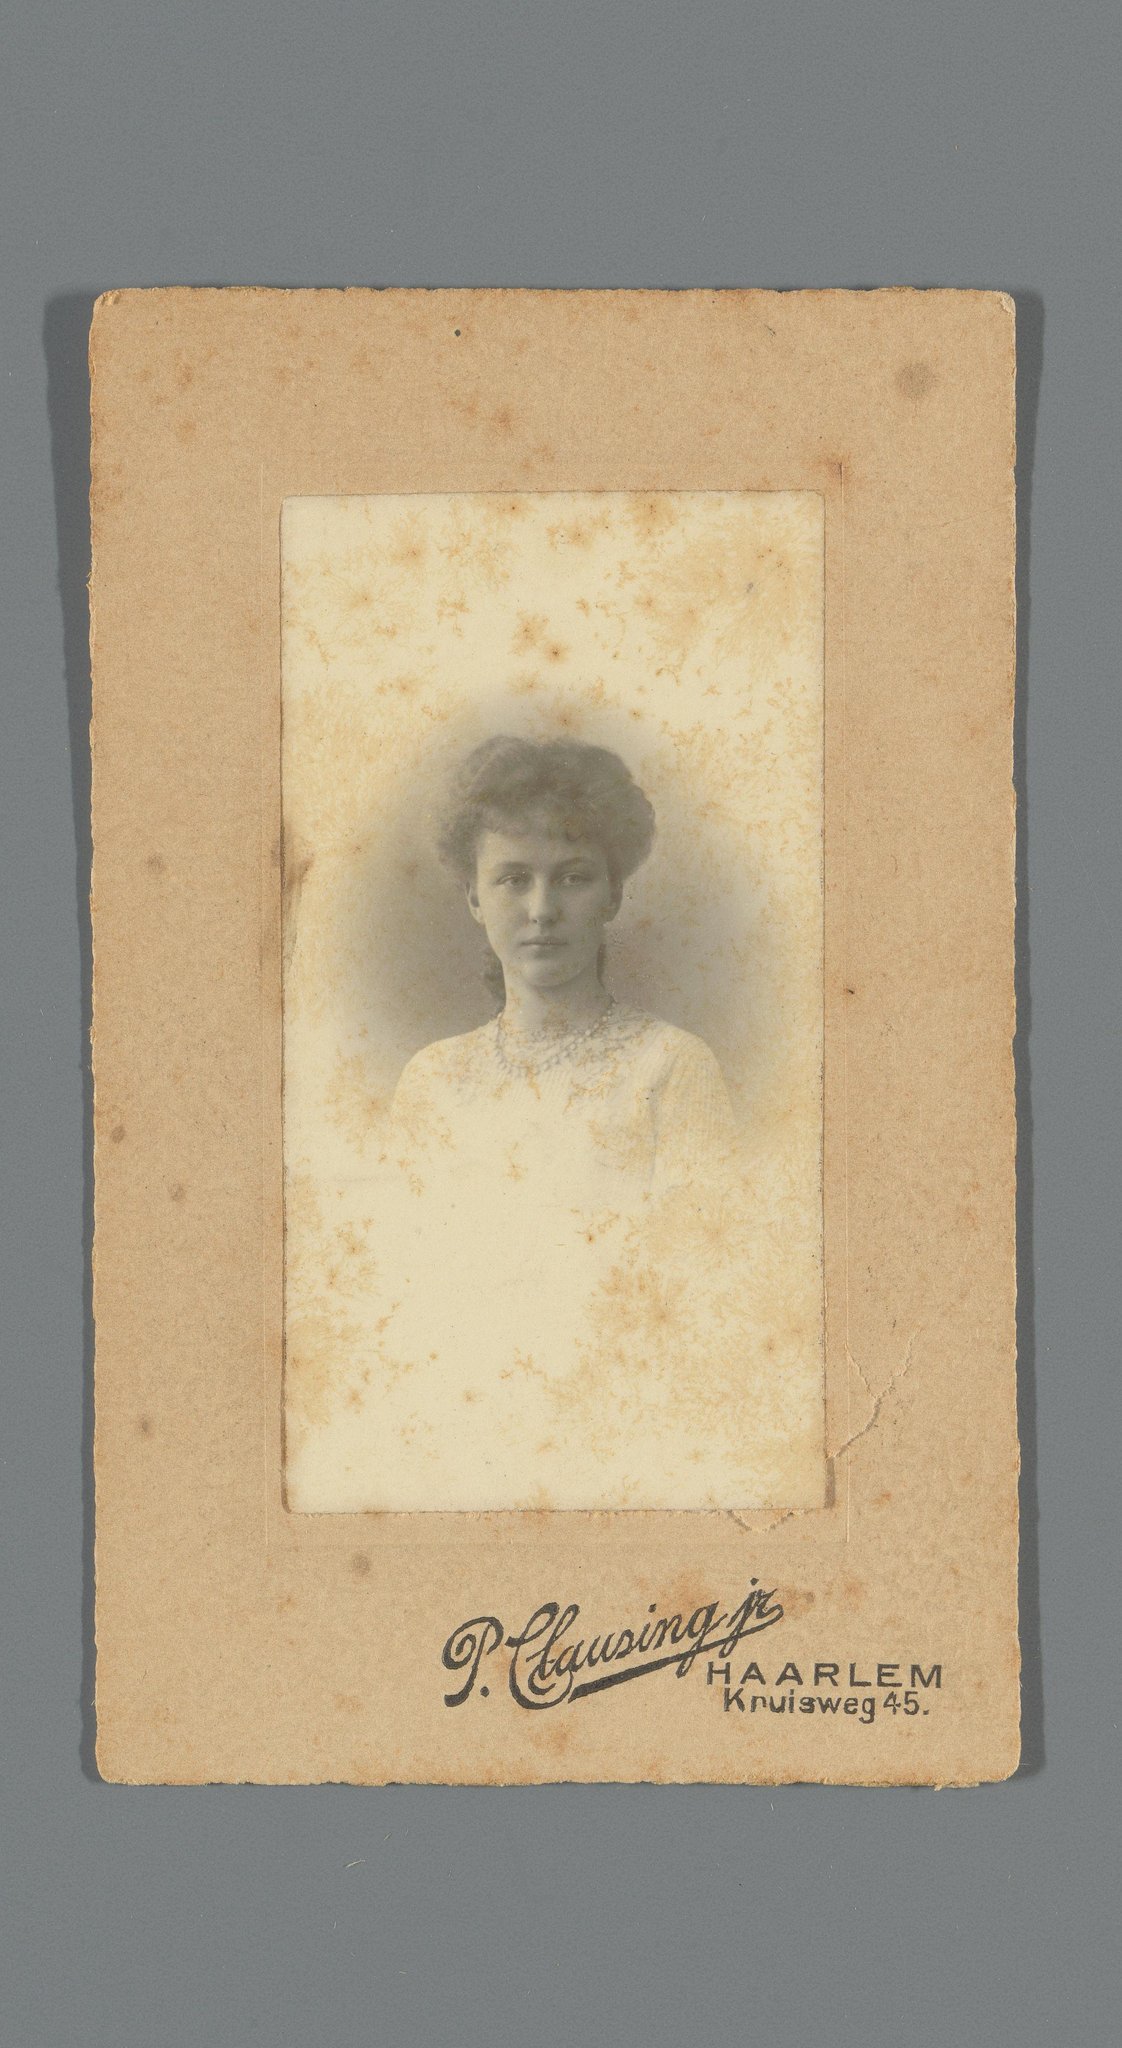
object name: carte de visite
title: Portret van Jkvr. Ida Helena Reusz de Ráthony-Teding van Berkhout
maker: peter clausing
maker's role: fotograaf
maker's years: 1870-1913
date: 1905-1915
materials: cardboard, photographic support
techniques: photography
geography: haarlem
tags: historical persons - bb - woman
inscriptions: annotation: ‘Ida, dochter van Fred. TvB en Sophie TvB-Van Taack Trakranen’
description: Portret van Jkvr. Ida Helena Reusz de Ráthony-Teding van Berkhout.